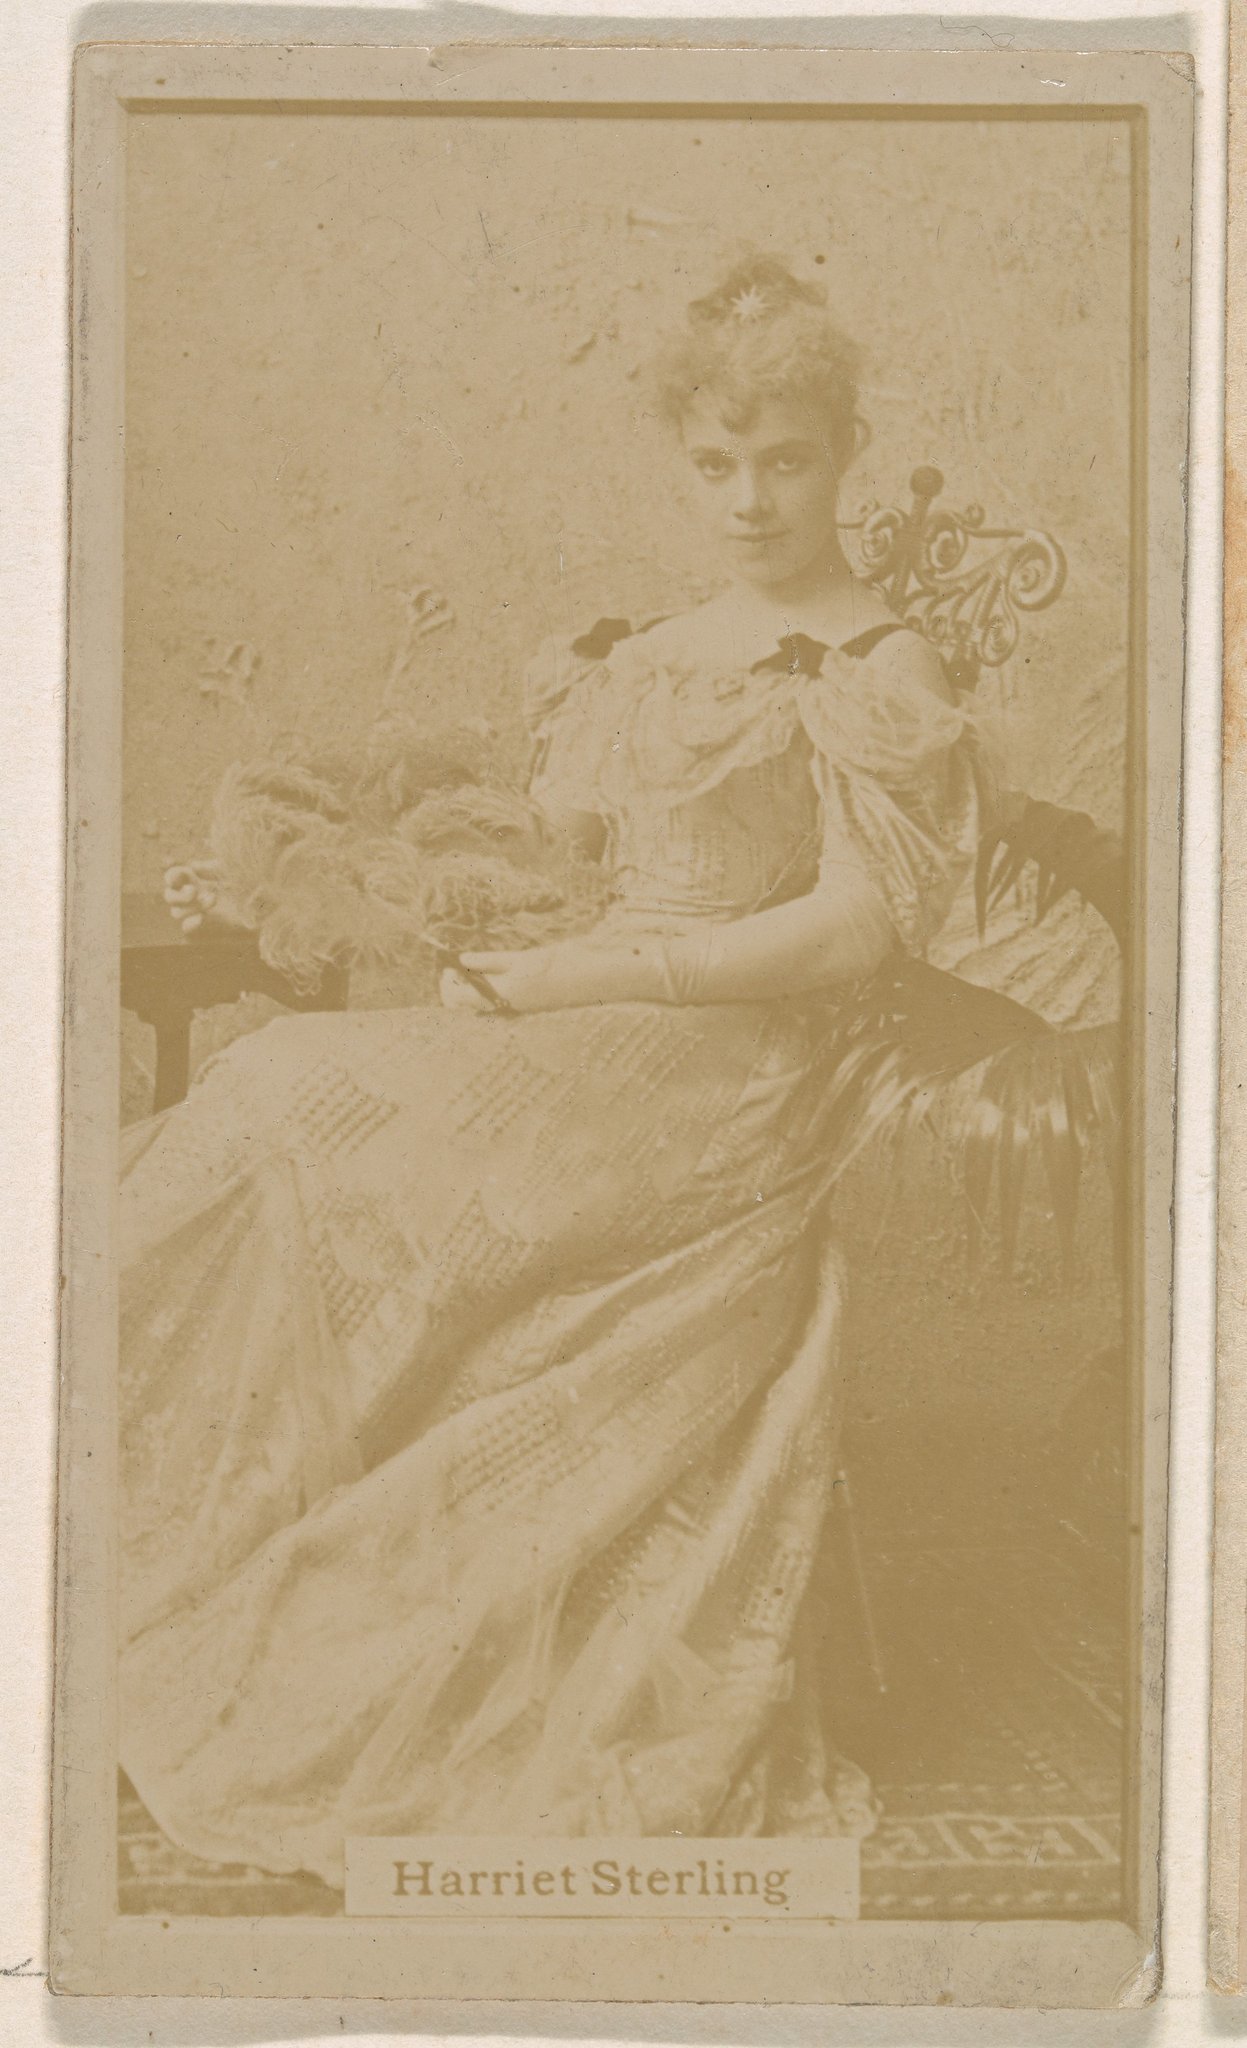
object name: photograph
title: Harriet Sterling, from the Actresses series (N245) issued by Kinney Brothers to promote Sweet Caporal Cigarettes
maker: kinney brothers tobacco company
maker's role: publisher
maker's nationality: american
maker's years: 1869-2011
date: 1890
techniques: albumen silver print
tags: portraits,women,actresses